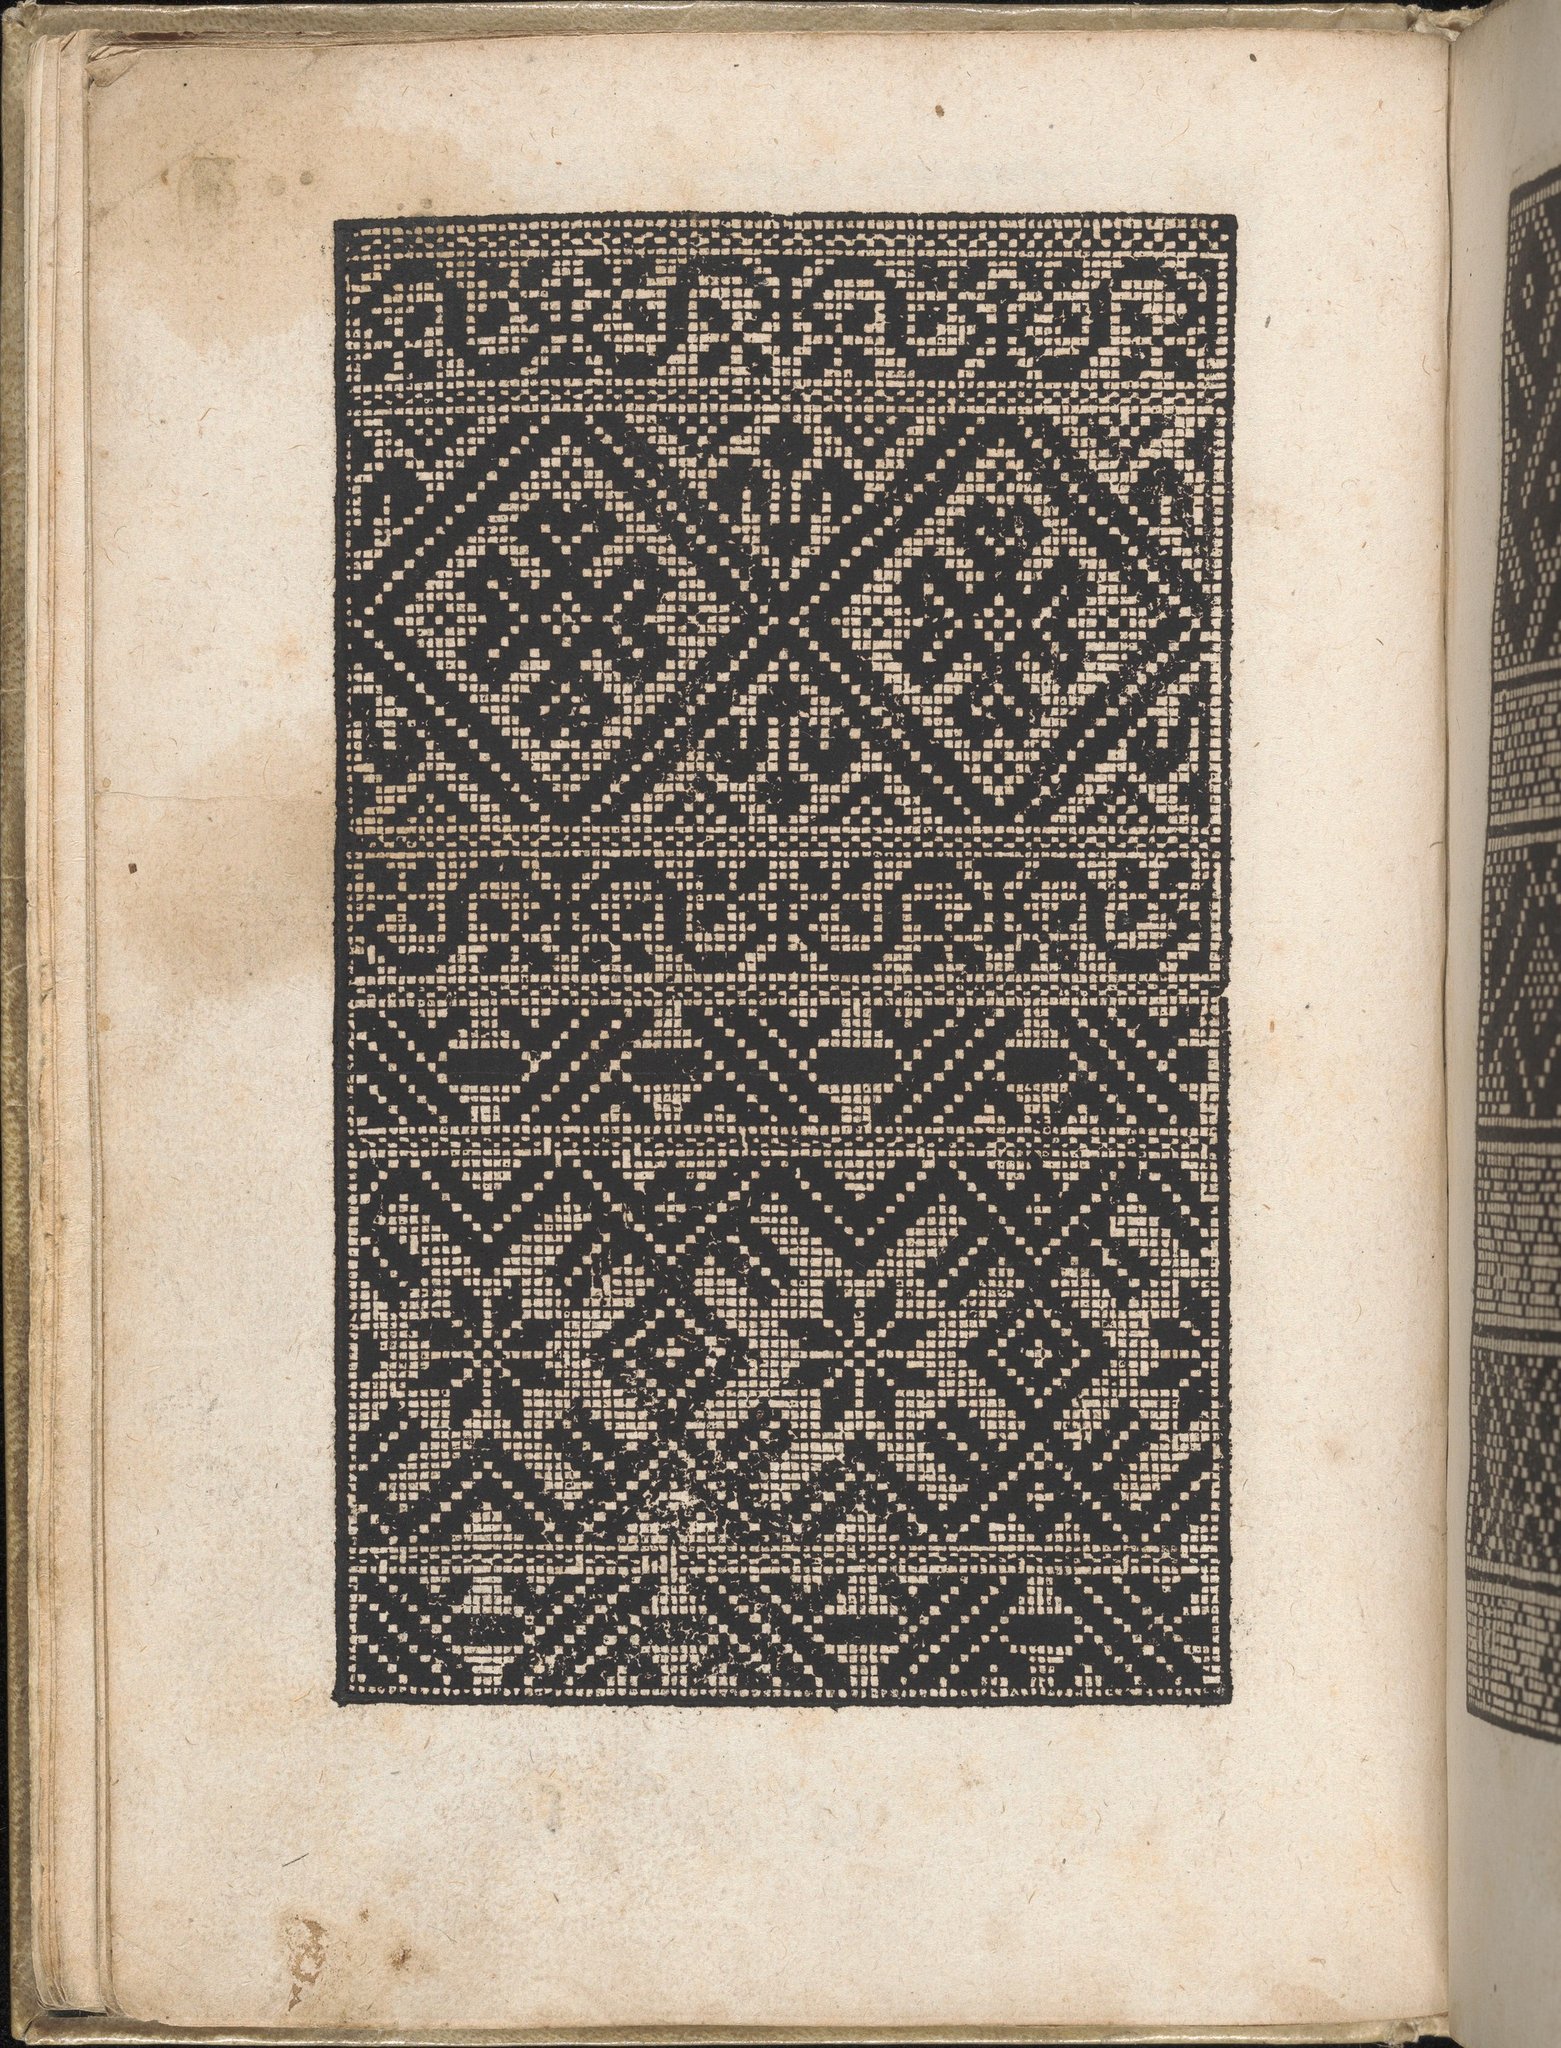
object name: book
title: Page 10v, from "Eyn New Kunstlichboich"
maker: peter quentel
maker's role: publisher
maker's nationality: german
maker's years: 1500-1550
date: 1529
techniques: woodcut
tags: ornament